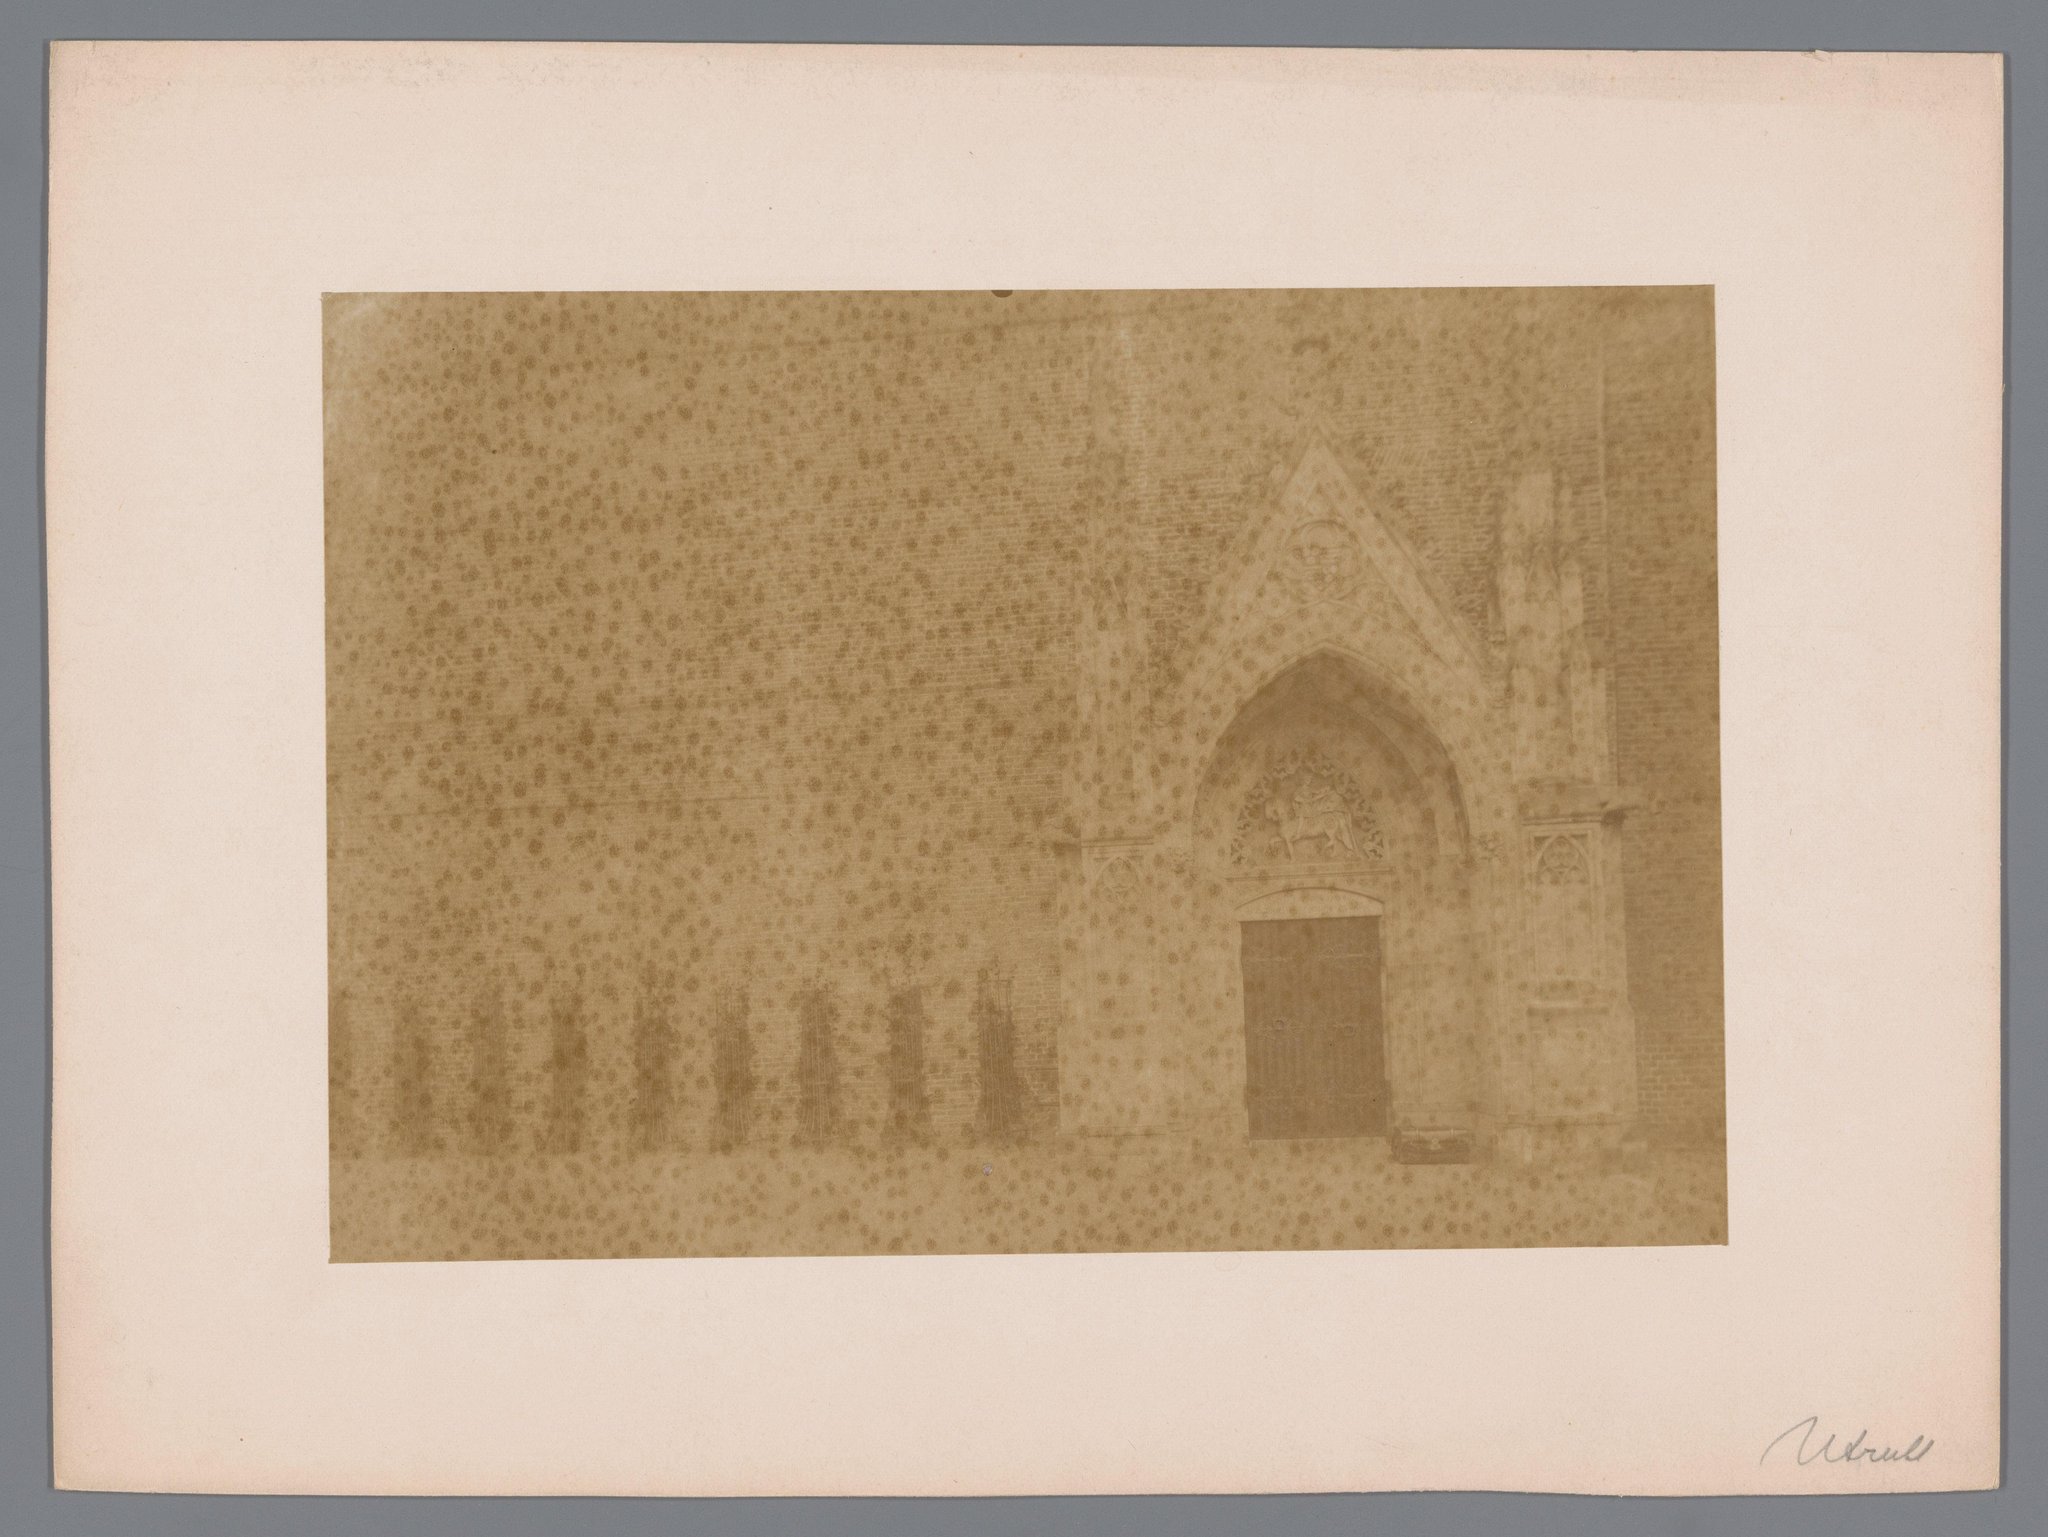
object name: photograph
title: Westmuur van het klooster bij de Dom van Utrecht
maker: anoniem (monumentenzorg)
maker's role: fotograaf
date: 1890-1910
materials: cardboard, photographic support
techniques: albumen print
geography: utrecht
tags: cloisters ~ monastery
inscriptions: annotation: ‘Utrecht’, annotation: ‘Westmuur v/d kloostergang te Utrecht’